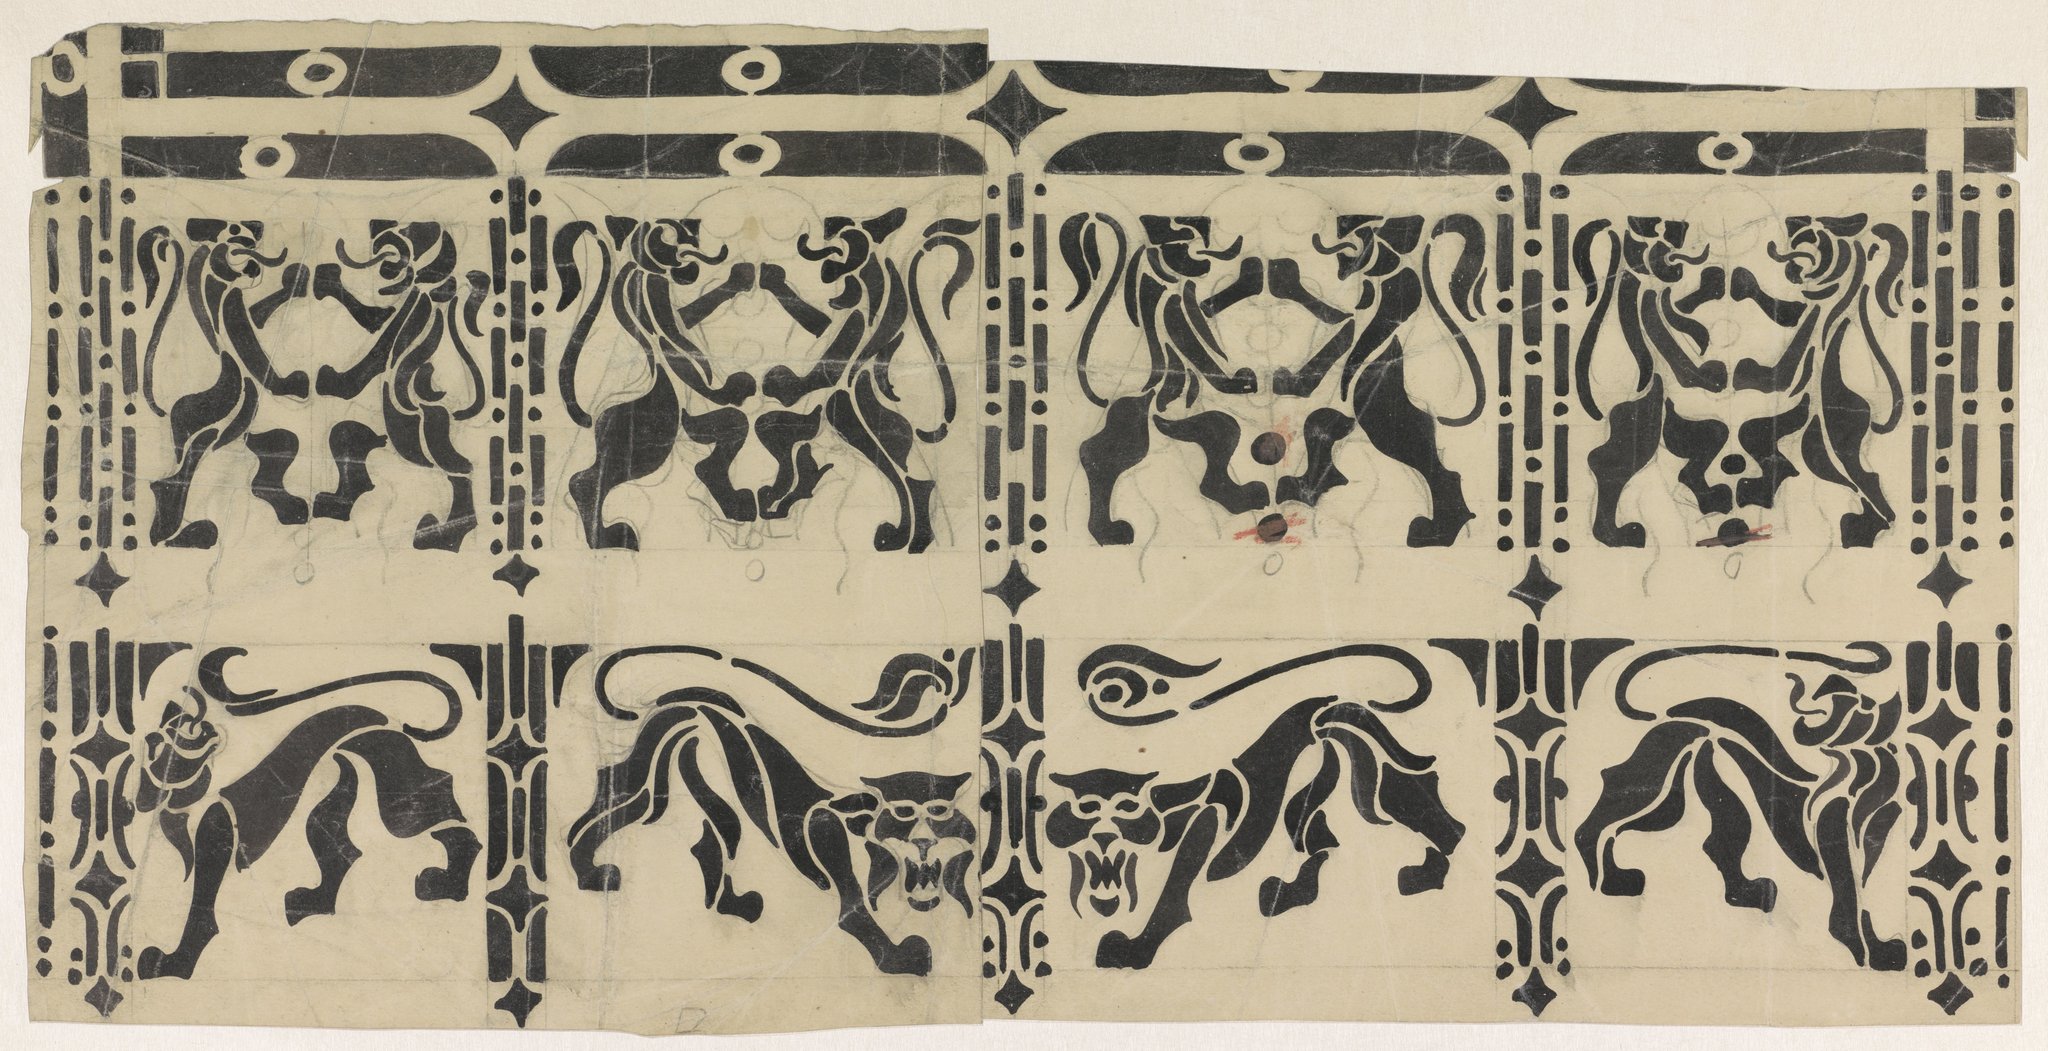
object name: drawing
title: Ontwerp met zes leeuwen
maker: carel adolph lion cachet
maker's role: draughtsman, print maker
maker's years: 1864-1945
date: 1874-1945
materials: paper, pencil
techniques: brush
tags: other ornament derived from animal forms, beasts of prey, predatory animals: lion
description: RP-T-1969-413 en RP-T-1969-414 passen aaneen.